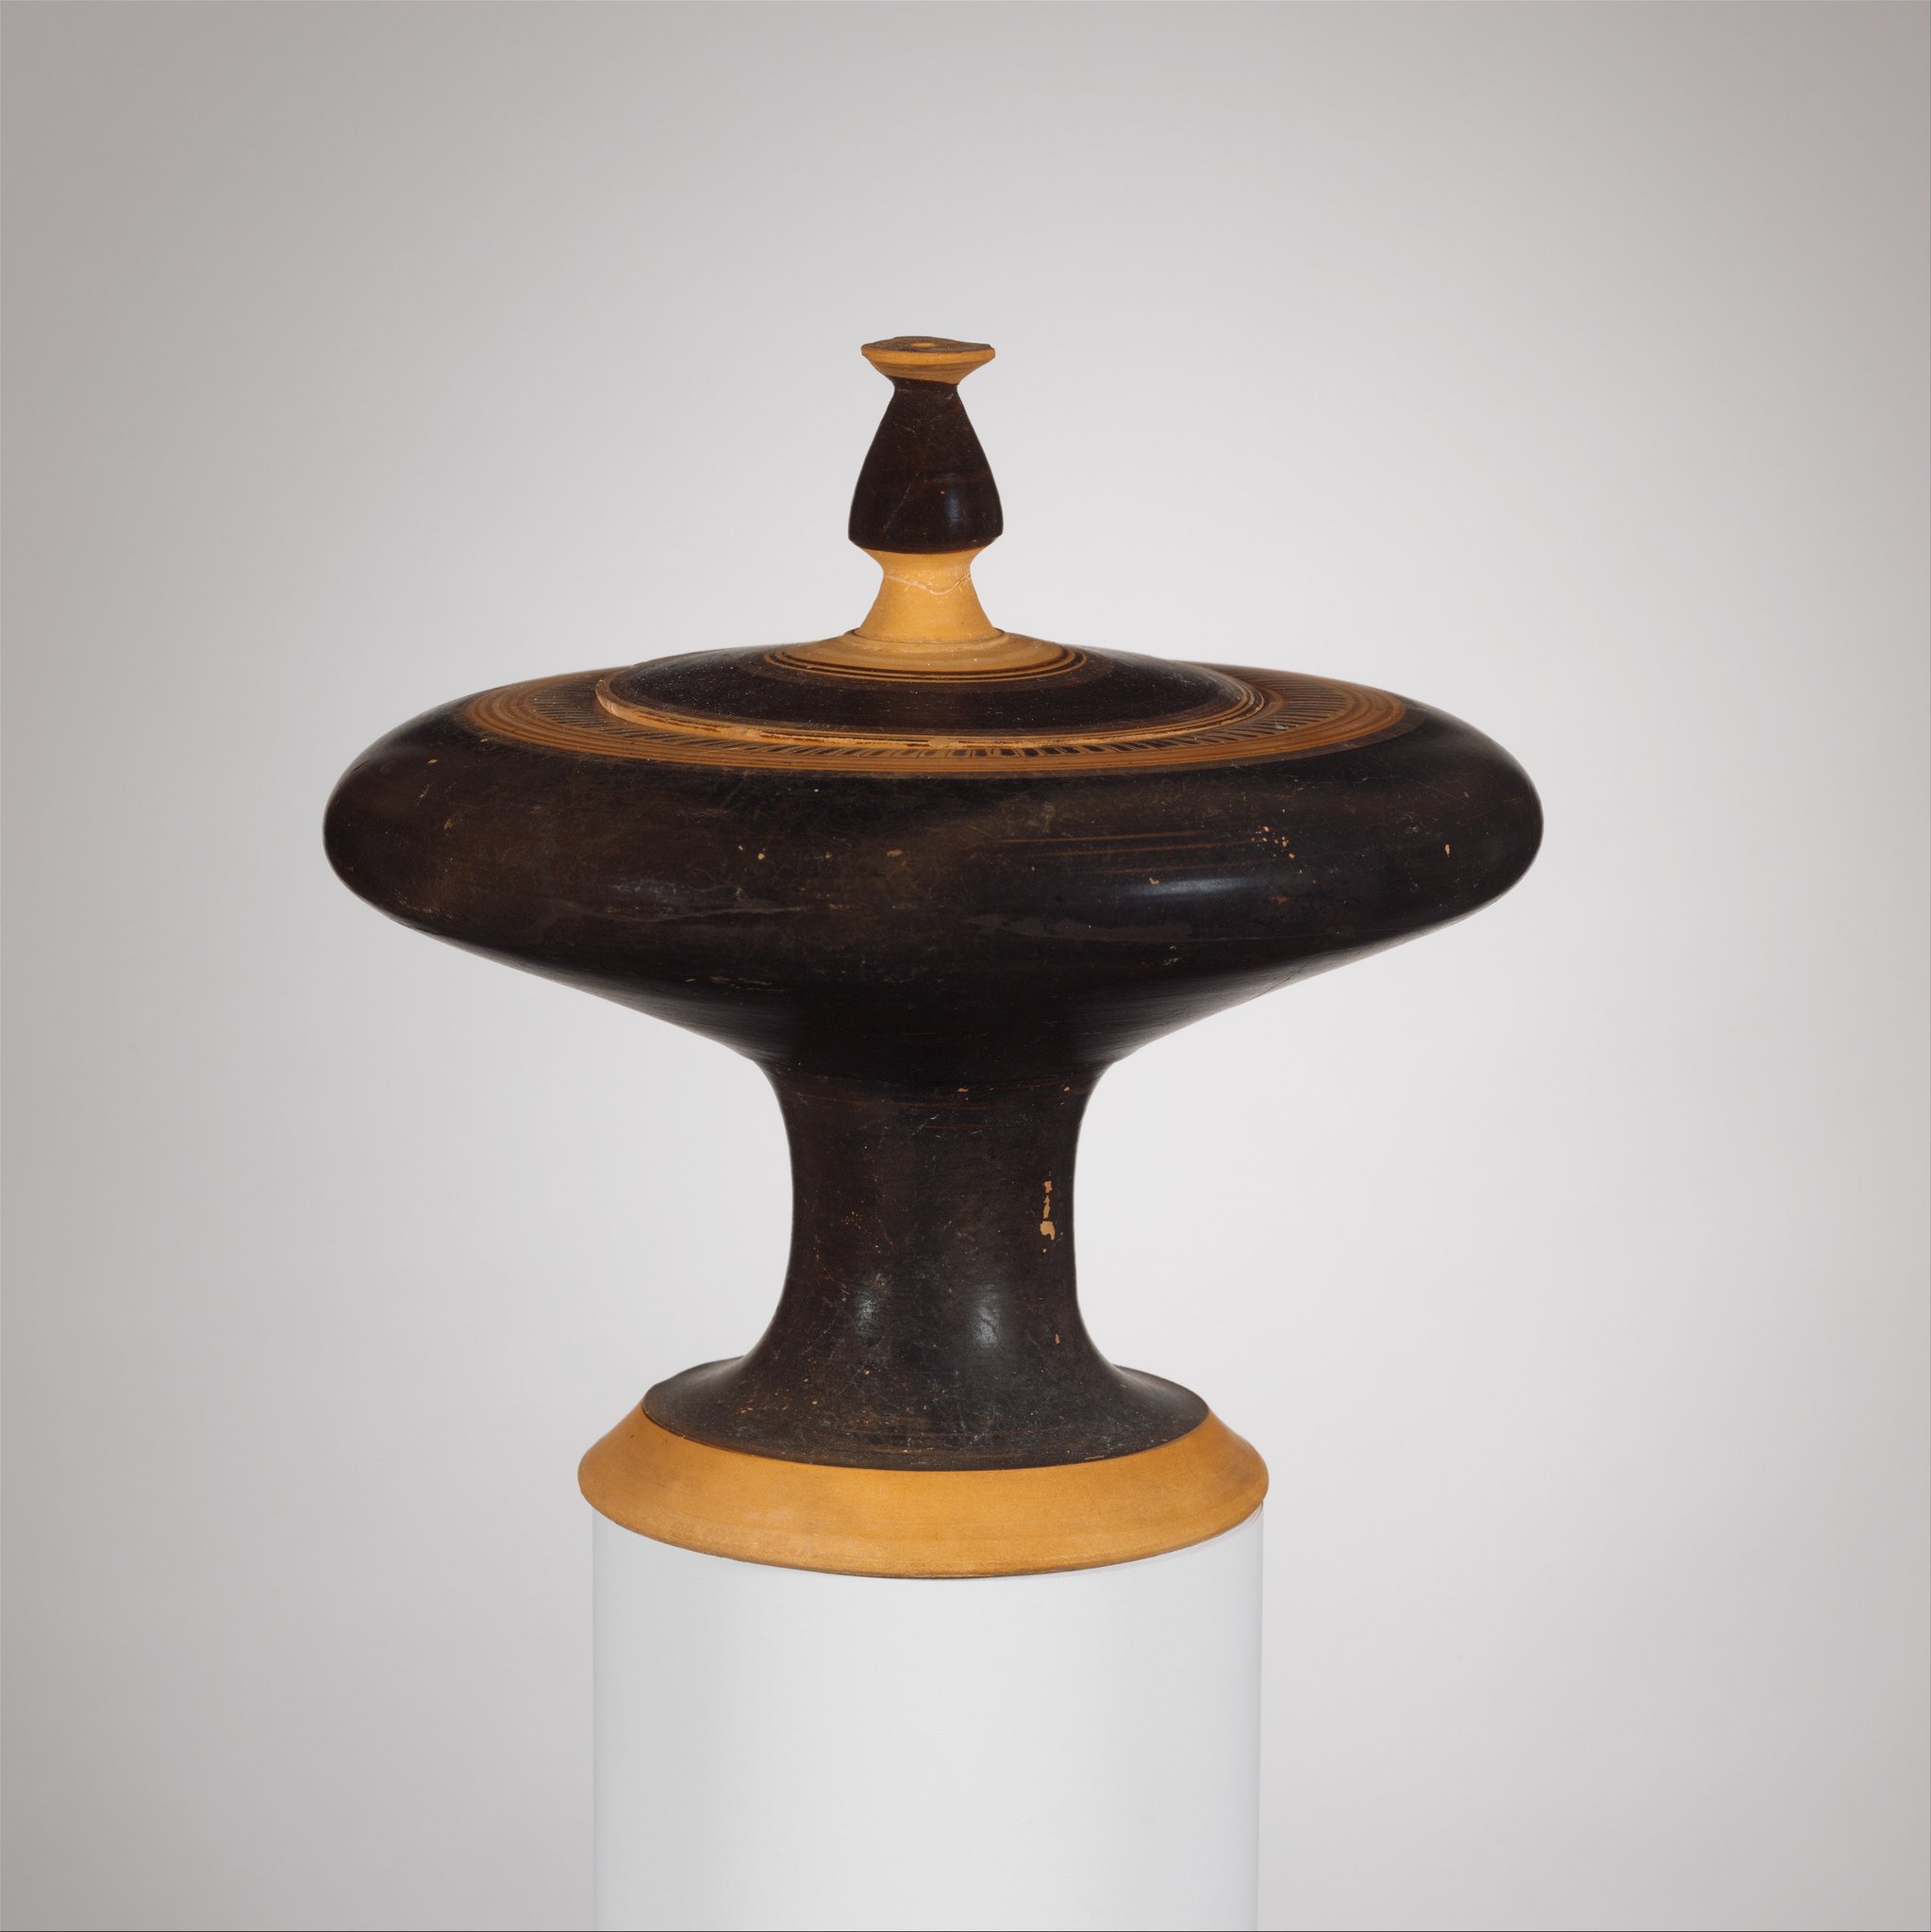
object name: plemochoe with lid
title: Terracotta plemochoe (vase for perfume)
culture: greek, attic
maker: kothons type b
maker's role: artist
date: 534-501 BCE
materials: terracotta